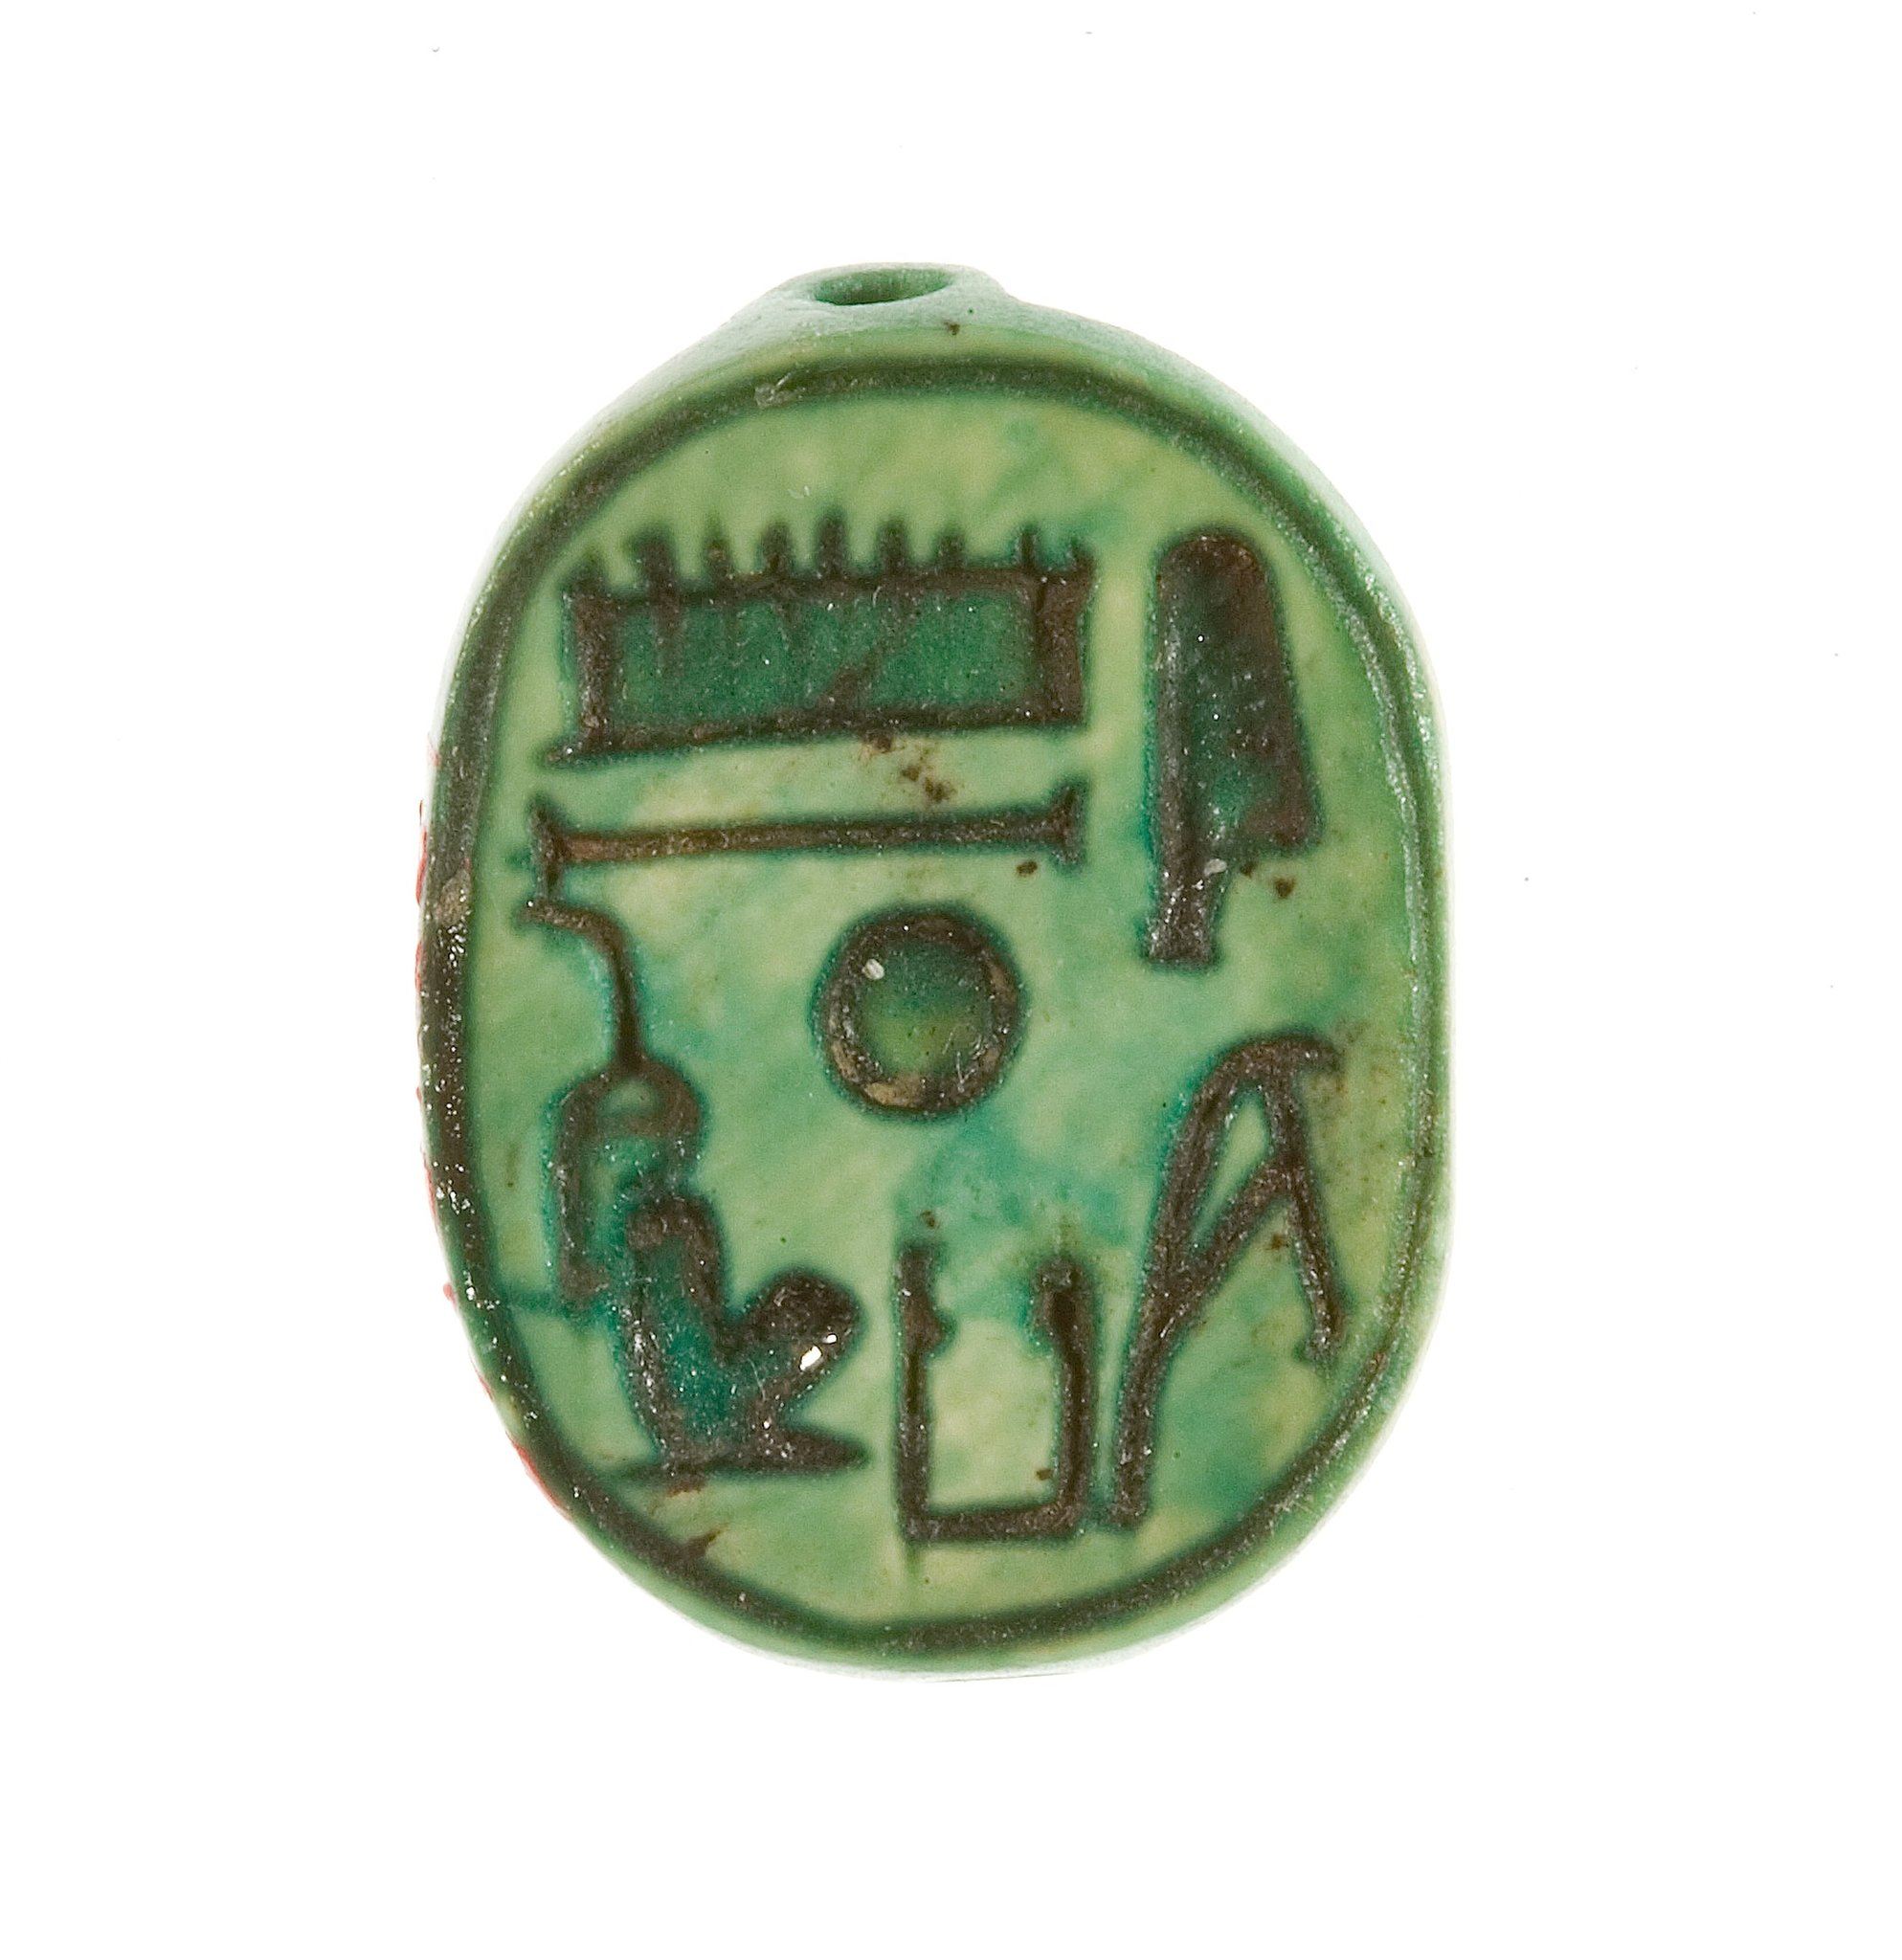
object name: wadjet eye, hatshepsut fd, maatkare, mery amun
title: Wadjet-eye Stamp Seal inscribed "Maatkare, Beloved of Amun"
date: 1479-1458 BCE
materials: stone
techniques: glazing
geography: egypt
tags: hieroglyphs